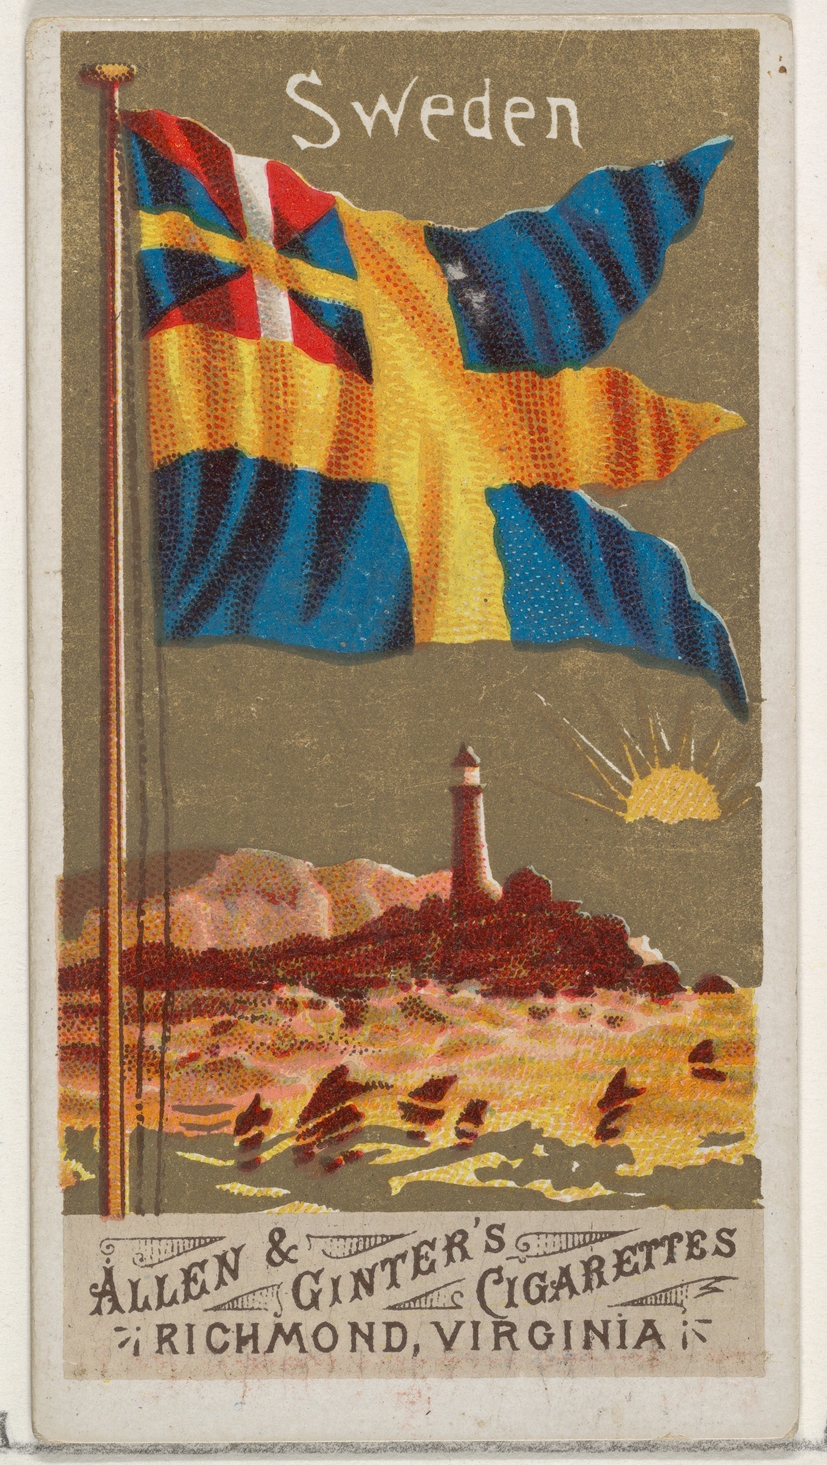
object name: print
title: Sweden, from Flags of All Nations, Series 1 (N9) for Allen & Ginter Cigarettes Brands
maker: allen & ginter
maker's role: publisher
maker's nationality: american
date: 1887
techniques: color lithograph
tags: flags